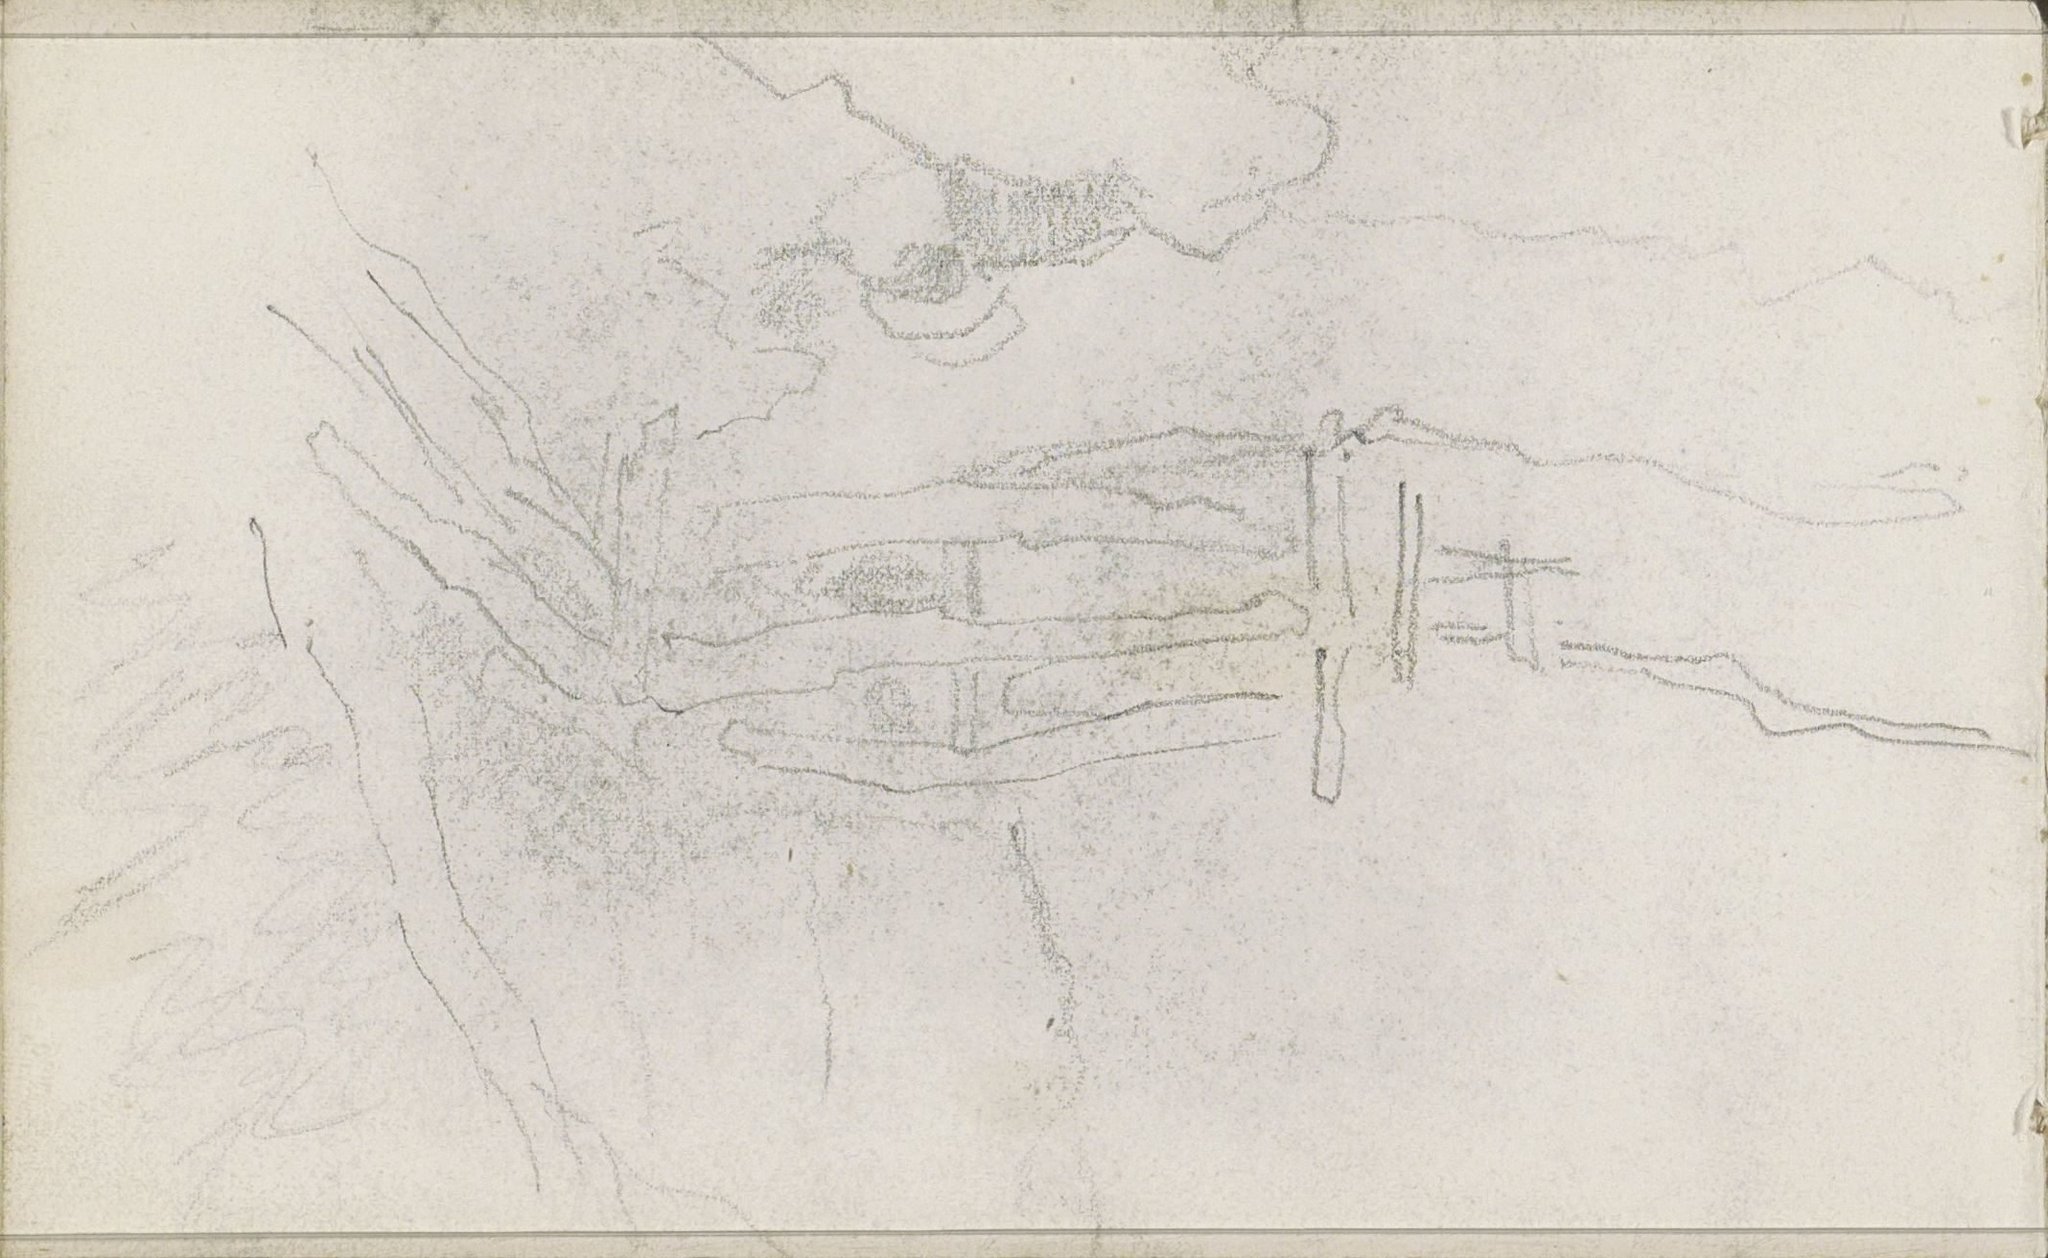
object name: sketchbook leaf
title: Stuk land afgezet met een hek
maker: anton mauve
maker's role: draughtsman, painter, print maker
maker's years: 1838-1888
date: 1848-1888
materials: paper, pencil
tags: landscapes, fence, wall, paling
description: Blad 6 verso uit een schetsboek met 43 bladen.